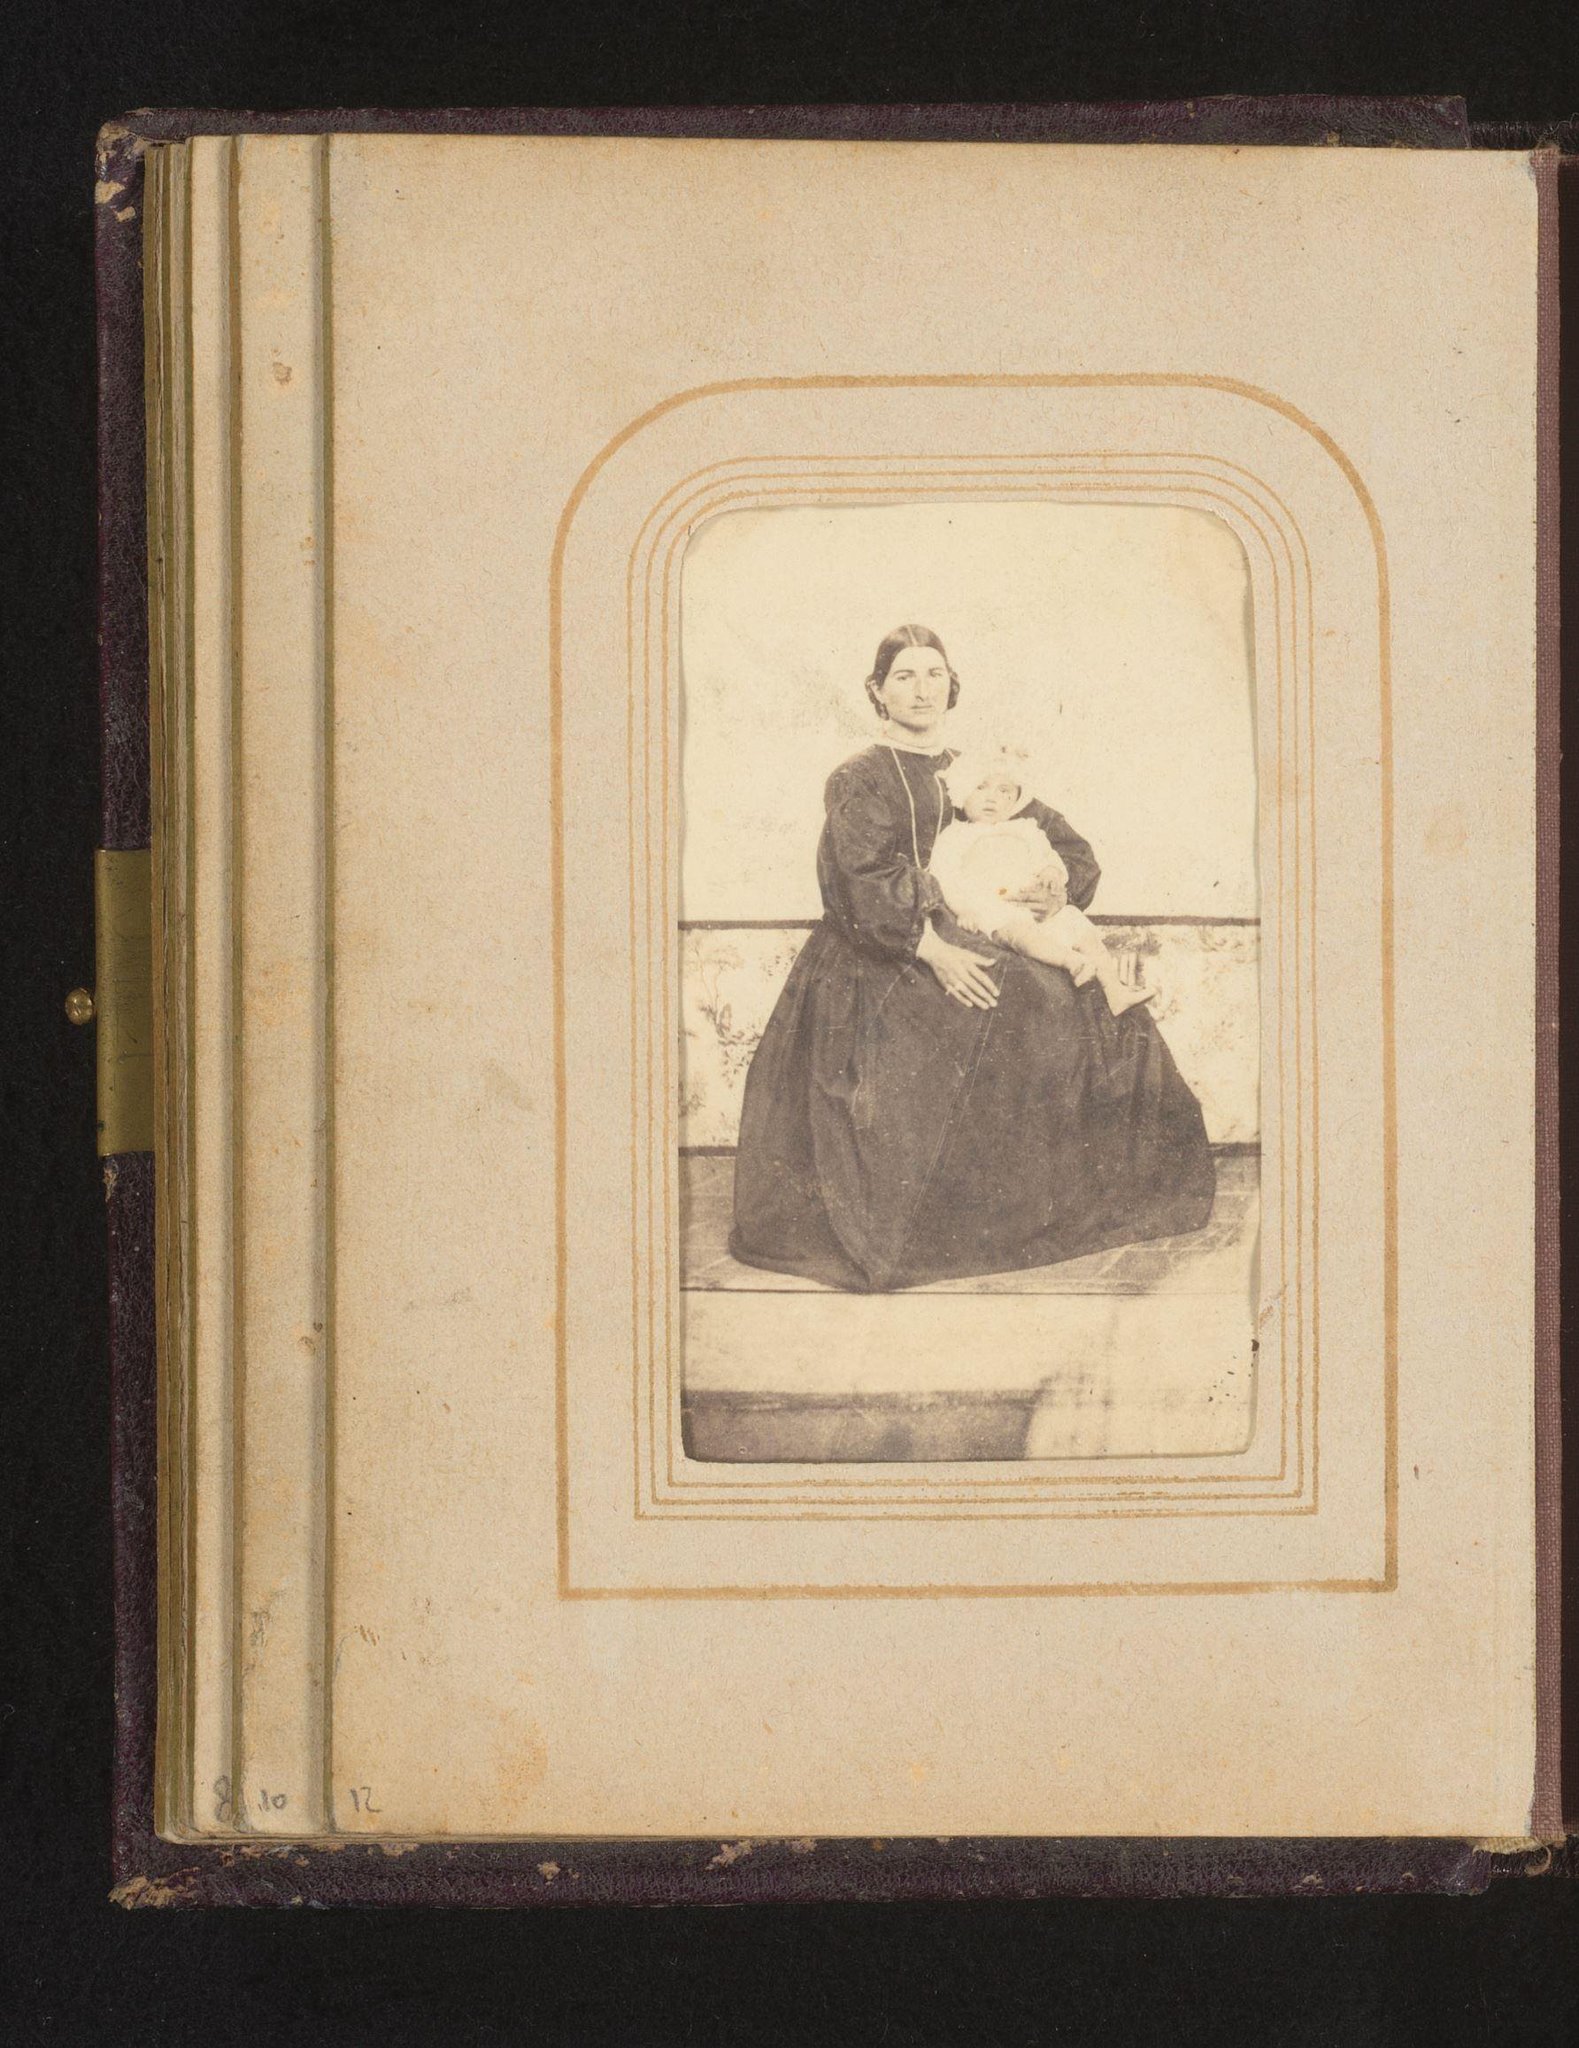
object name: photograph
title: Portret van een zittende moeder met kind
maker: Anonymous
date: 1860-1900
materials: cardboard, photographic support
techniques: albumen print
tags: mother and baby or young child